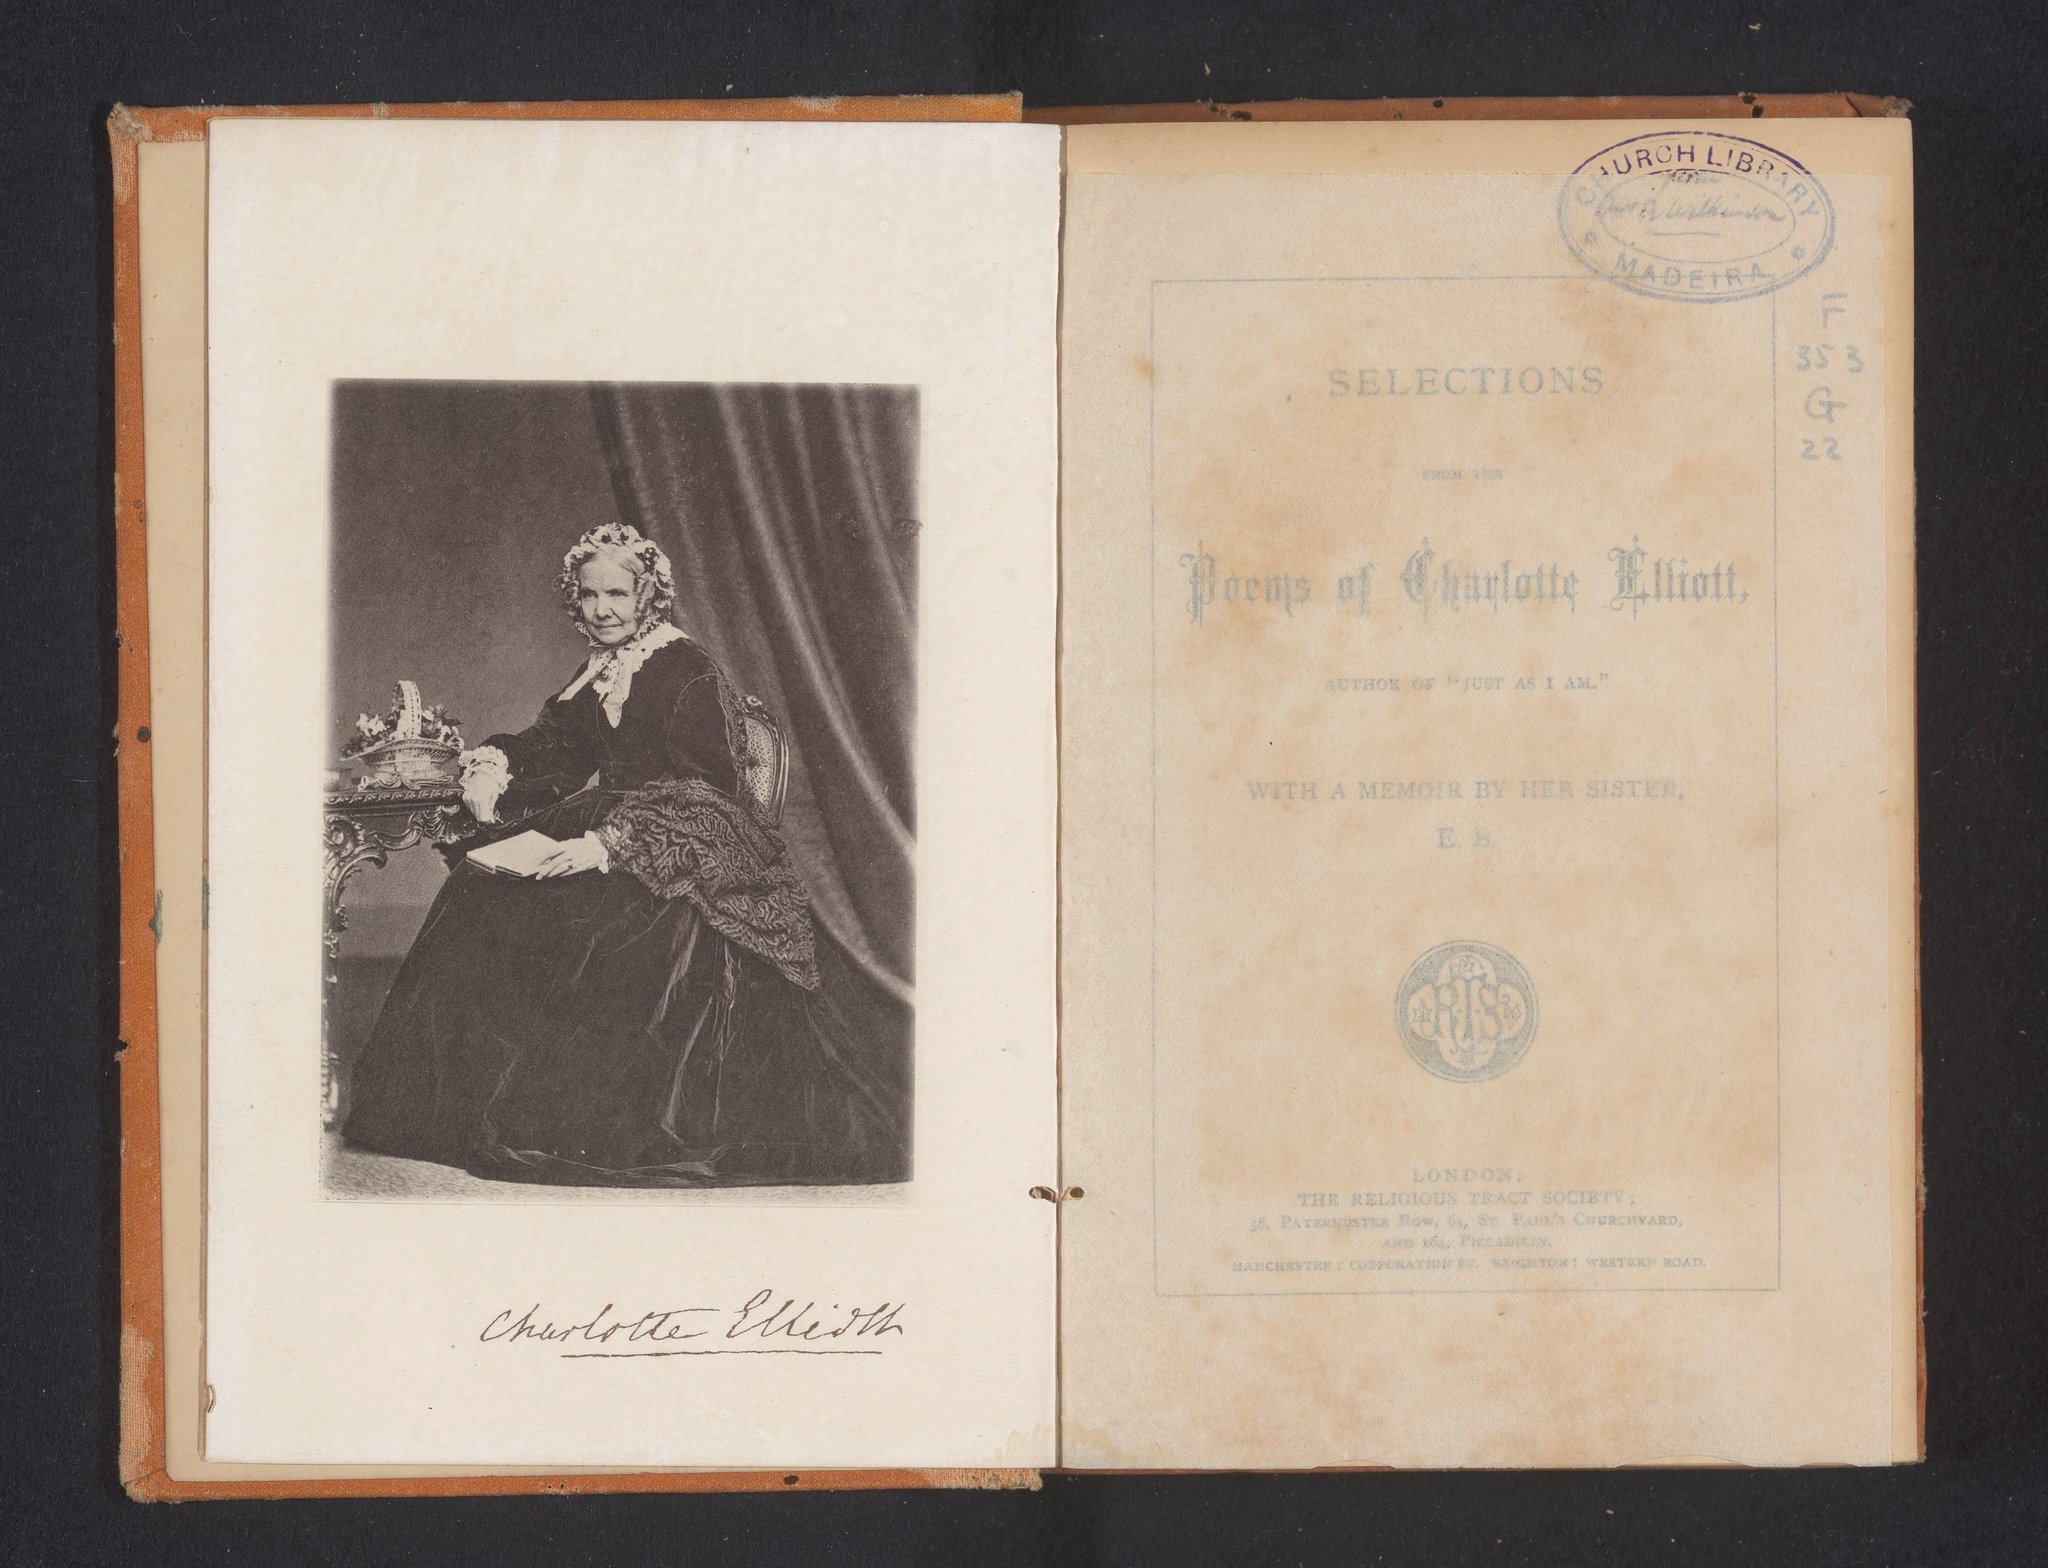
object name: page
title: Charlotte Elliott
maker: Anonymous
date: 1863-1871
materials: paper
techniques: photograph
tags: charlotte elliott, writer, poet, author